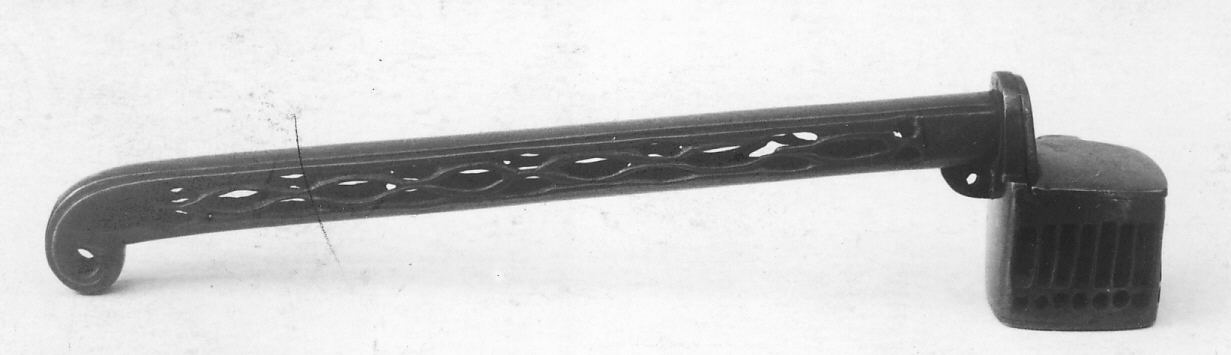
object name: pen case and ink well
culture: japanese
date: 1801-1900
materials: bronze